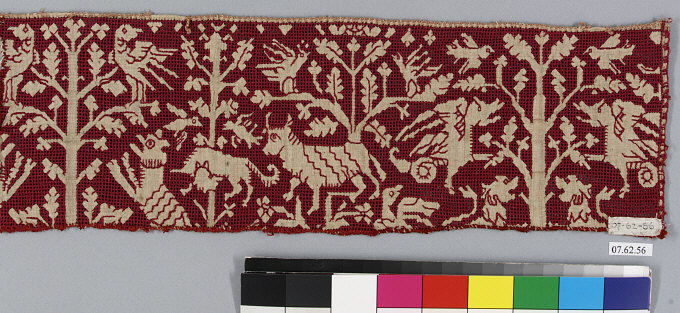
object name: band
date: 1601-1700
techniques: embroidery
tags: animals,trees